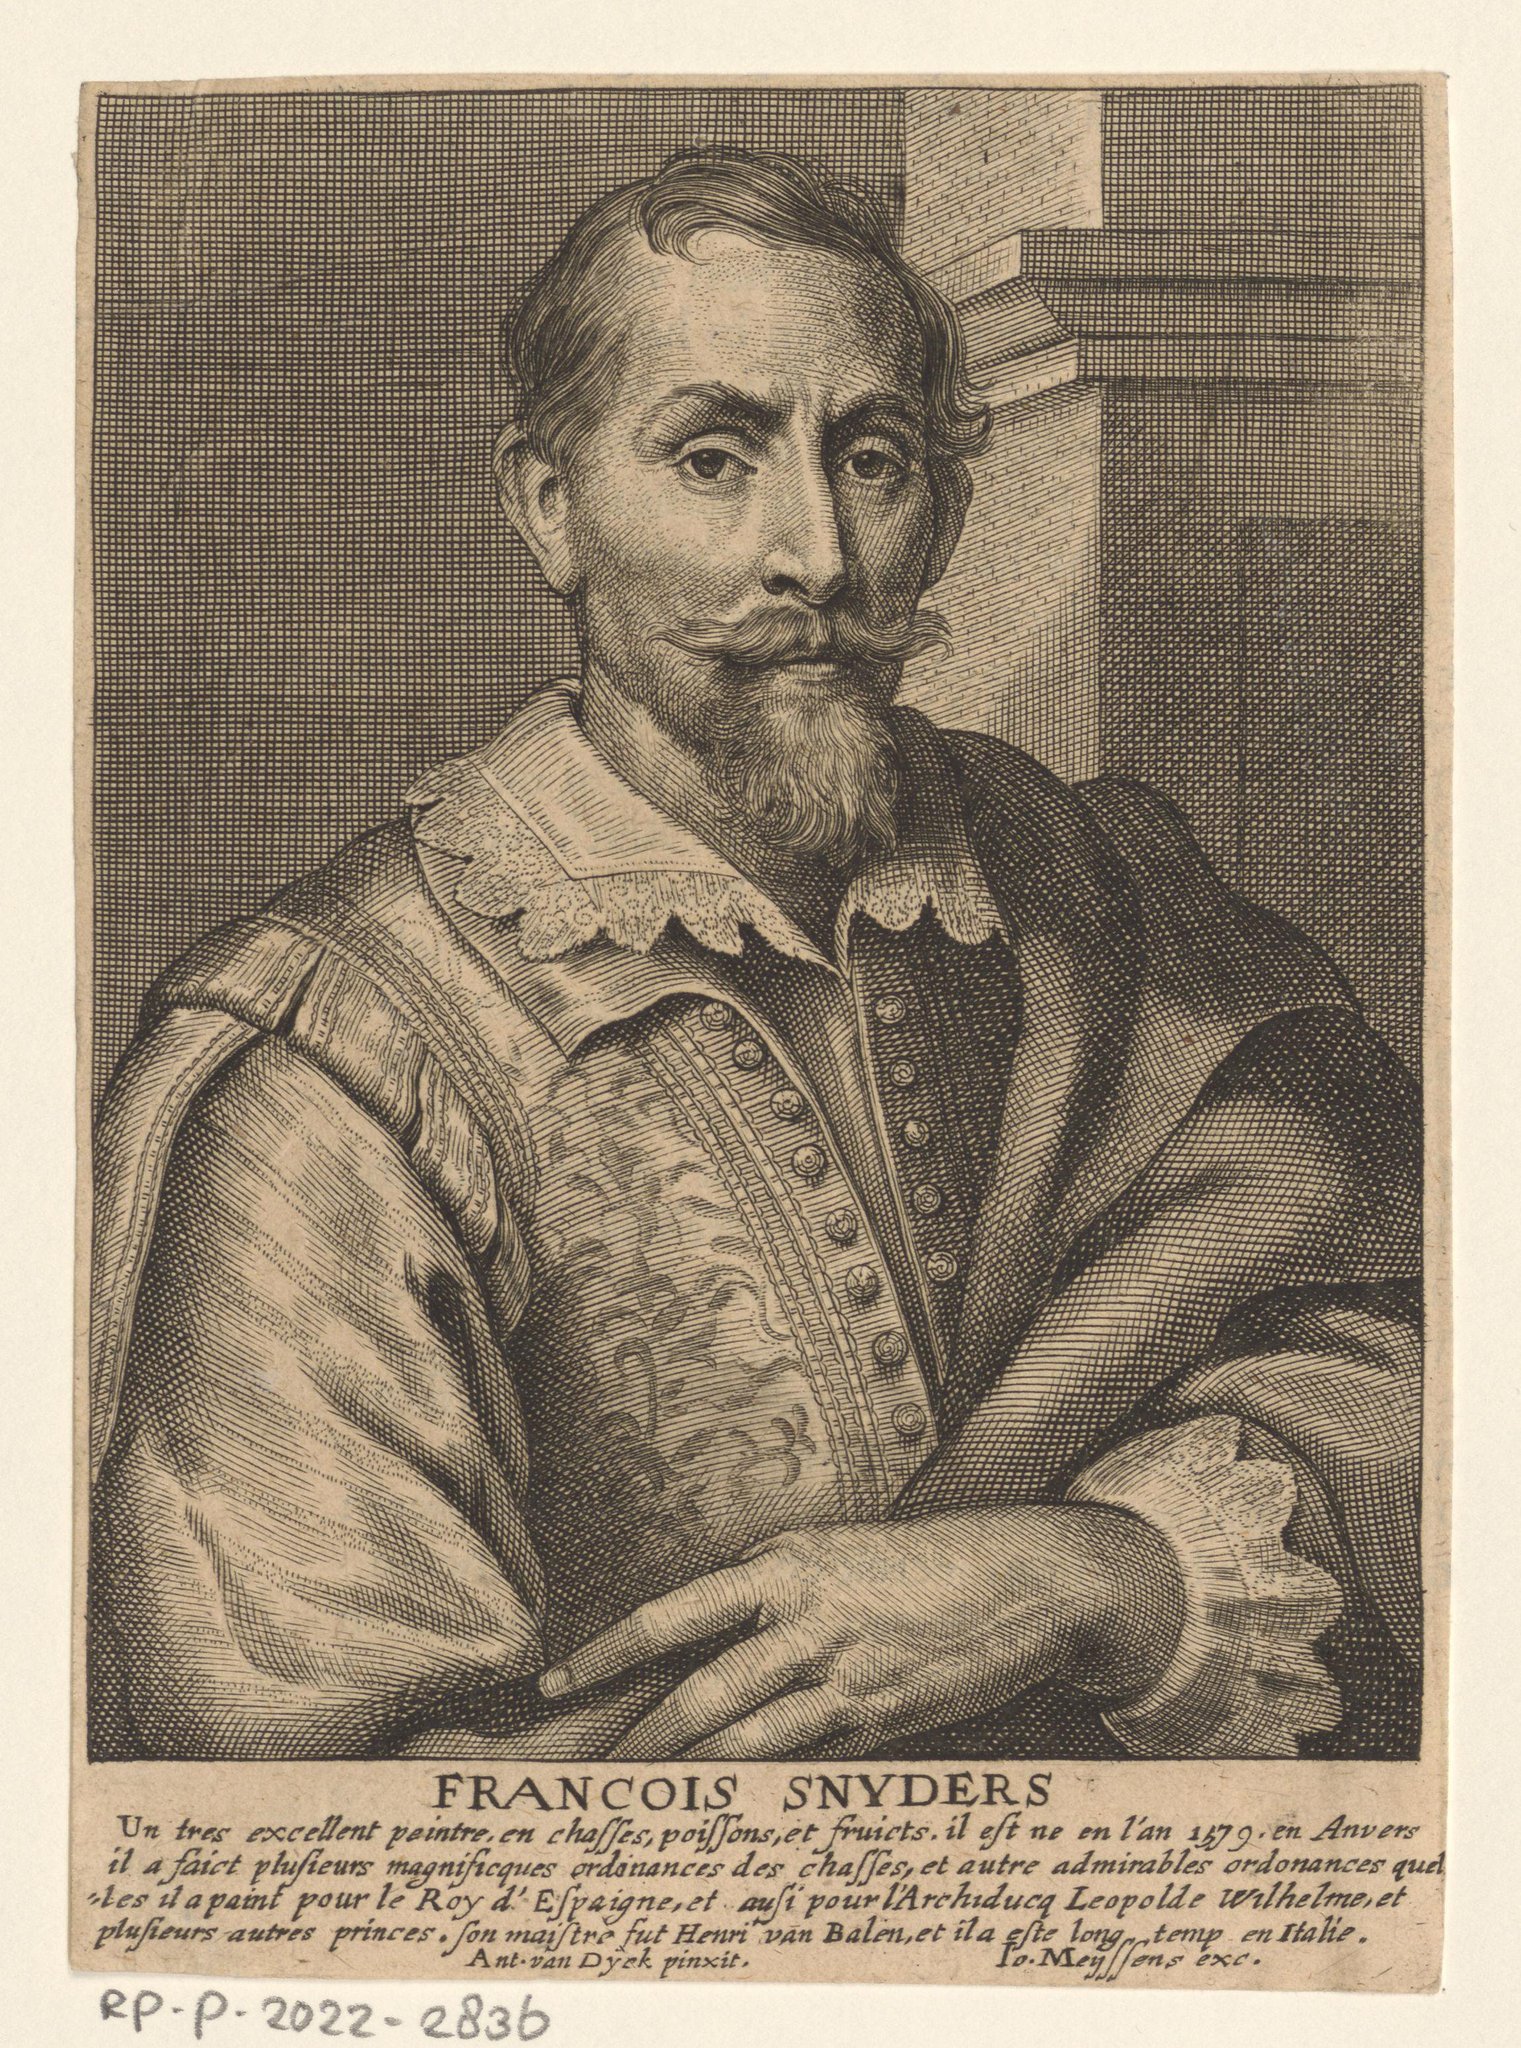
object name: print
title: Portret van Frans Snijders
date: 1662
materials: paper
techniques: engraving, etching, letterpress printing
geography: antwerp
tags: antwerp, draughtsman, frans snijders, historical persons, portrait, self-portrait of artist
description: Prent uit: Bie, Cornelis de. Het gulden Cabinet vande edel vry schilder const, inhoudende den lof vande vermarste schilders, architecte, beldthowers ende plaetsnyders van dese eeuw. Antwerpen: Joannes Meyssens, 1662 [1661 foutief op titelpagina].